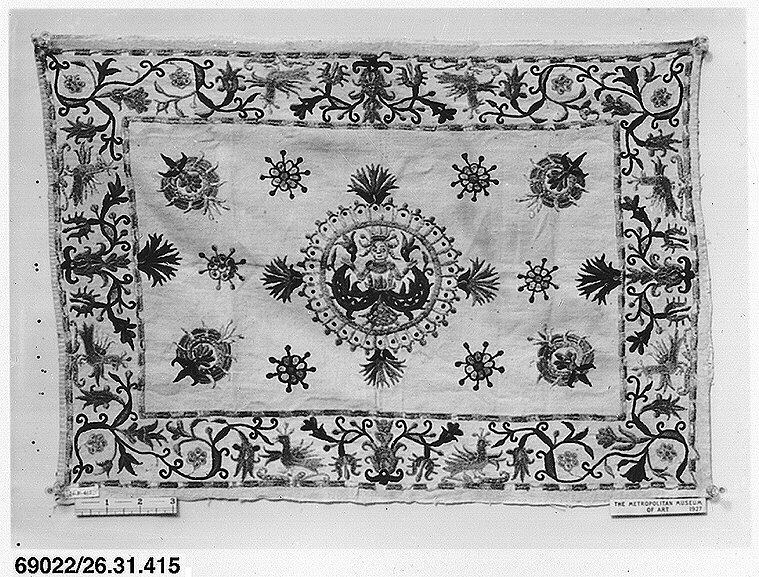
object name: pillow cover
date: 1701-1800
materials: linen, silk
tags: human figures,flowers